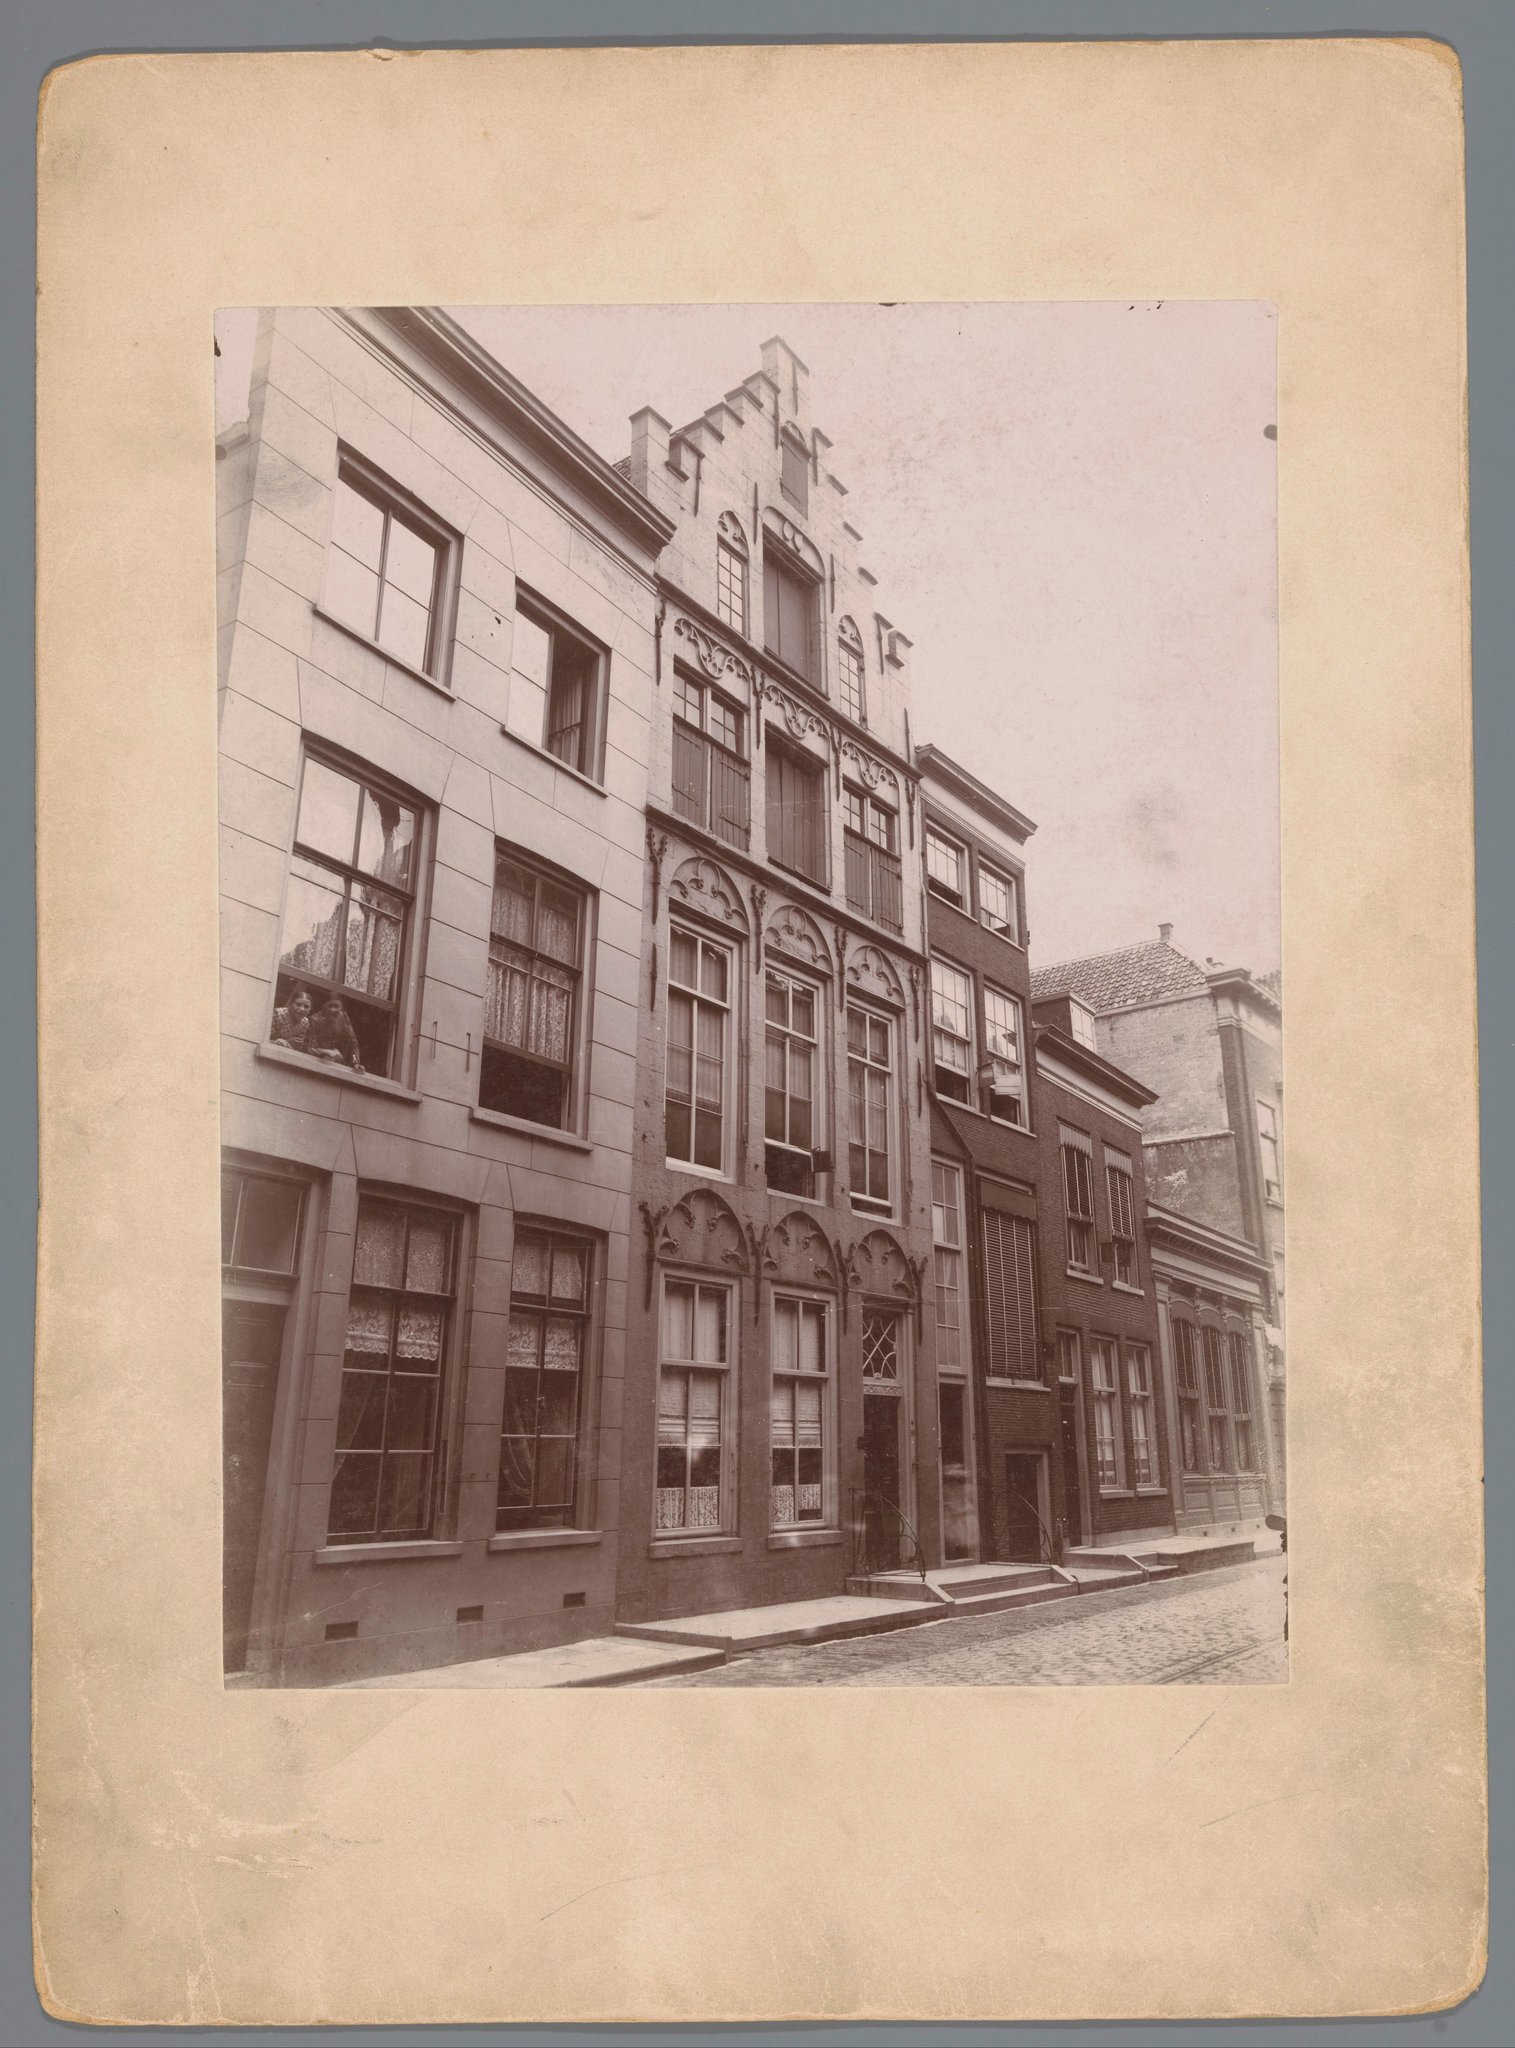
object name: photograph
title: Exterieur van Huis Het Zeepaard aan de Wijnstraat 59 in Dordrecht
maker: a.j.m. mulder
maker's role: engineer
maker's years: 1856-1936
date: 1875-1900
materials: cardboard, photographic support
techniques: daylight paper print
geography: wijnstraat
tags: façade (of house or building), street (+ city(-scape) with figures, staffage)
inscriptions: collector's mark: Lugt 3937, annotation:, inscription: ‘Gotisch woonhuis in de Wijnstraat te Dordrecht N:59’